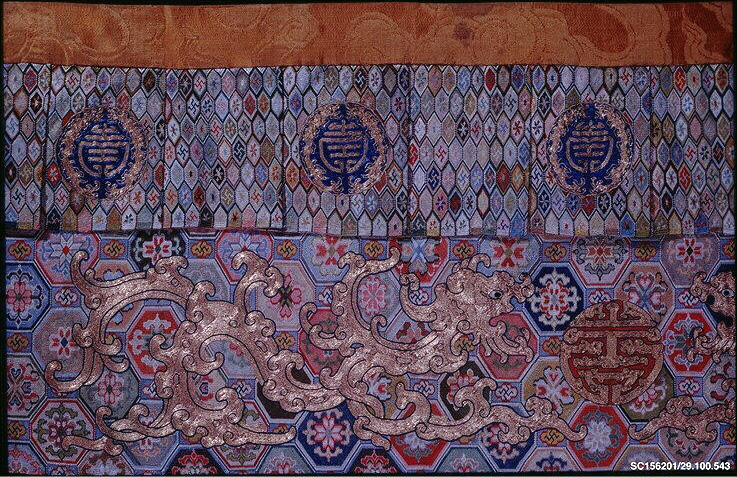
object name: valance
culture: chinese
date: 1601-1800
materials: metal thread, silk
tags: mythical creatures